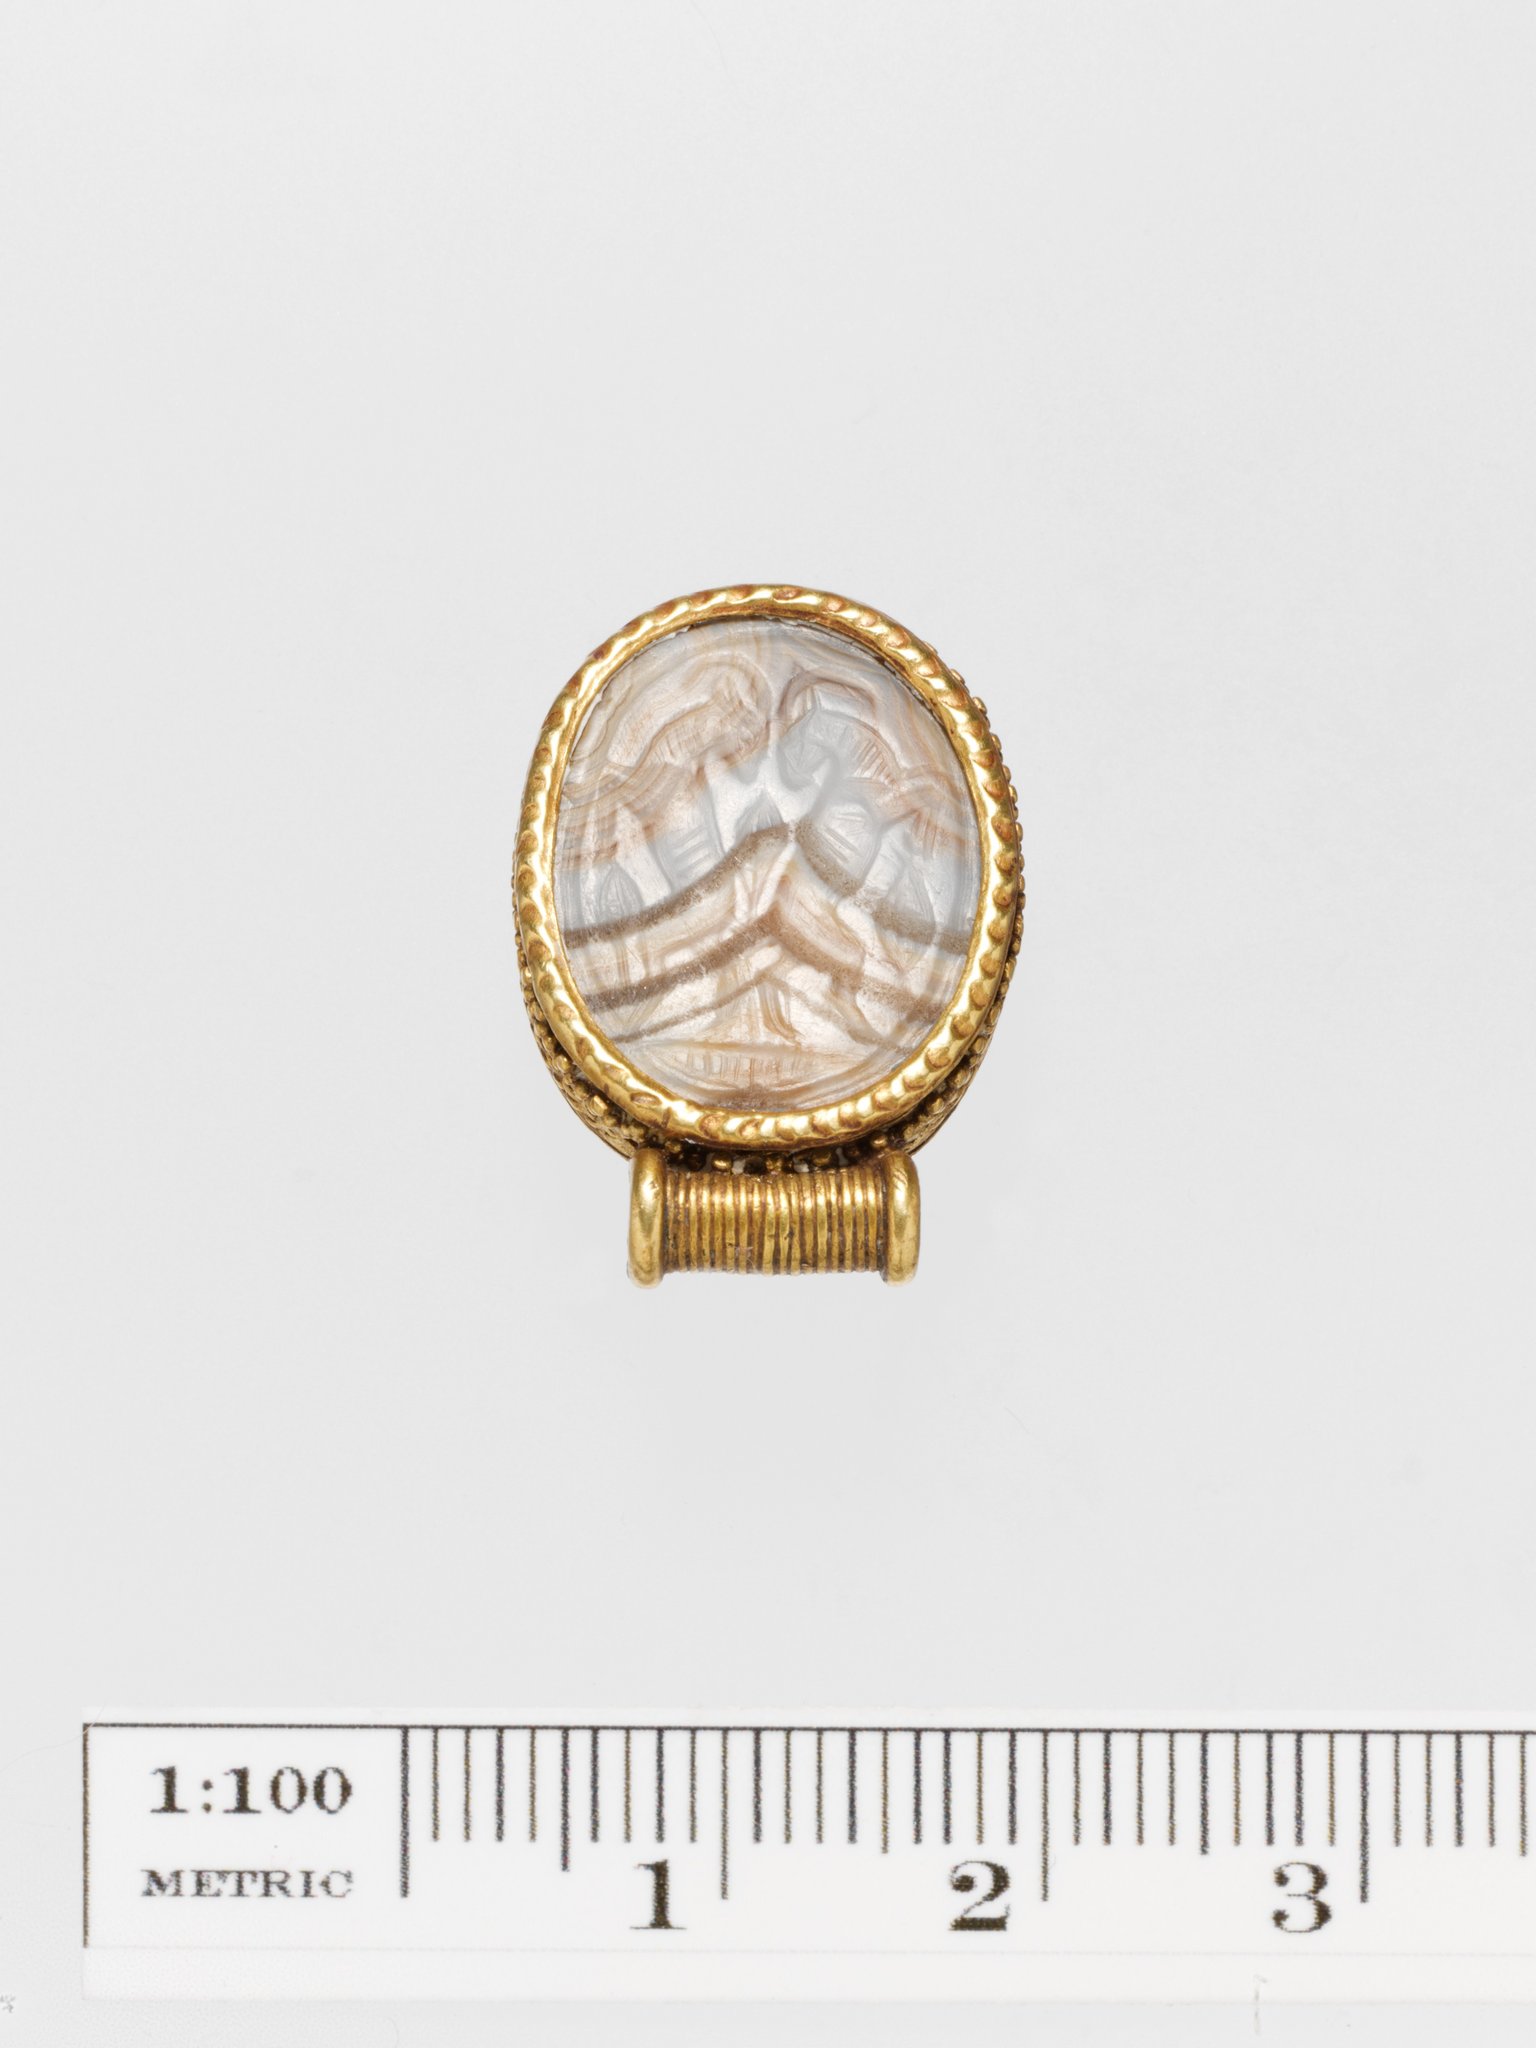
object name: intaglio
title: Agate oval seal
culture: greek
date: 600-501 BCE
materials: stone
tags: goats